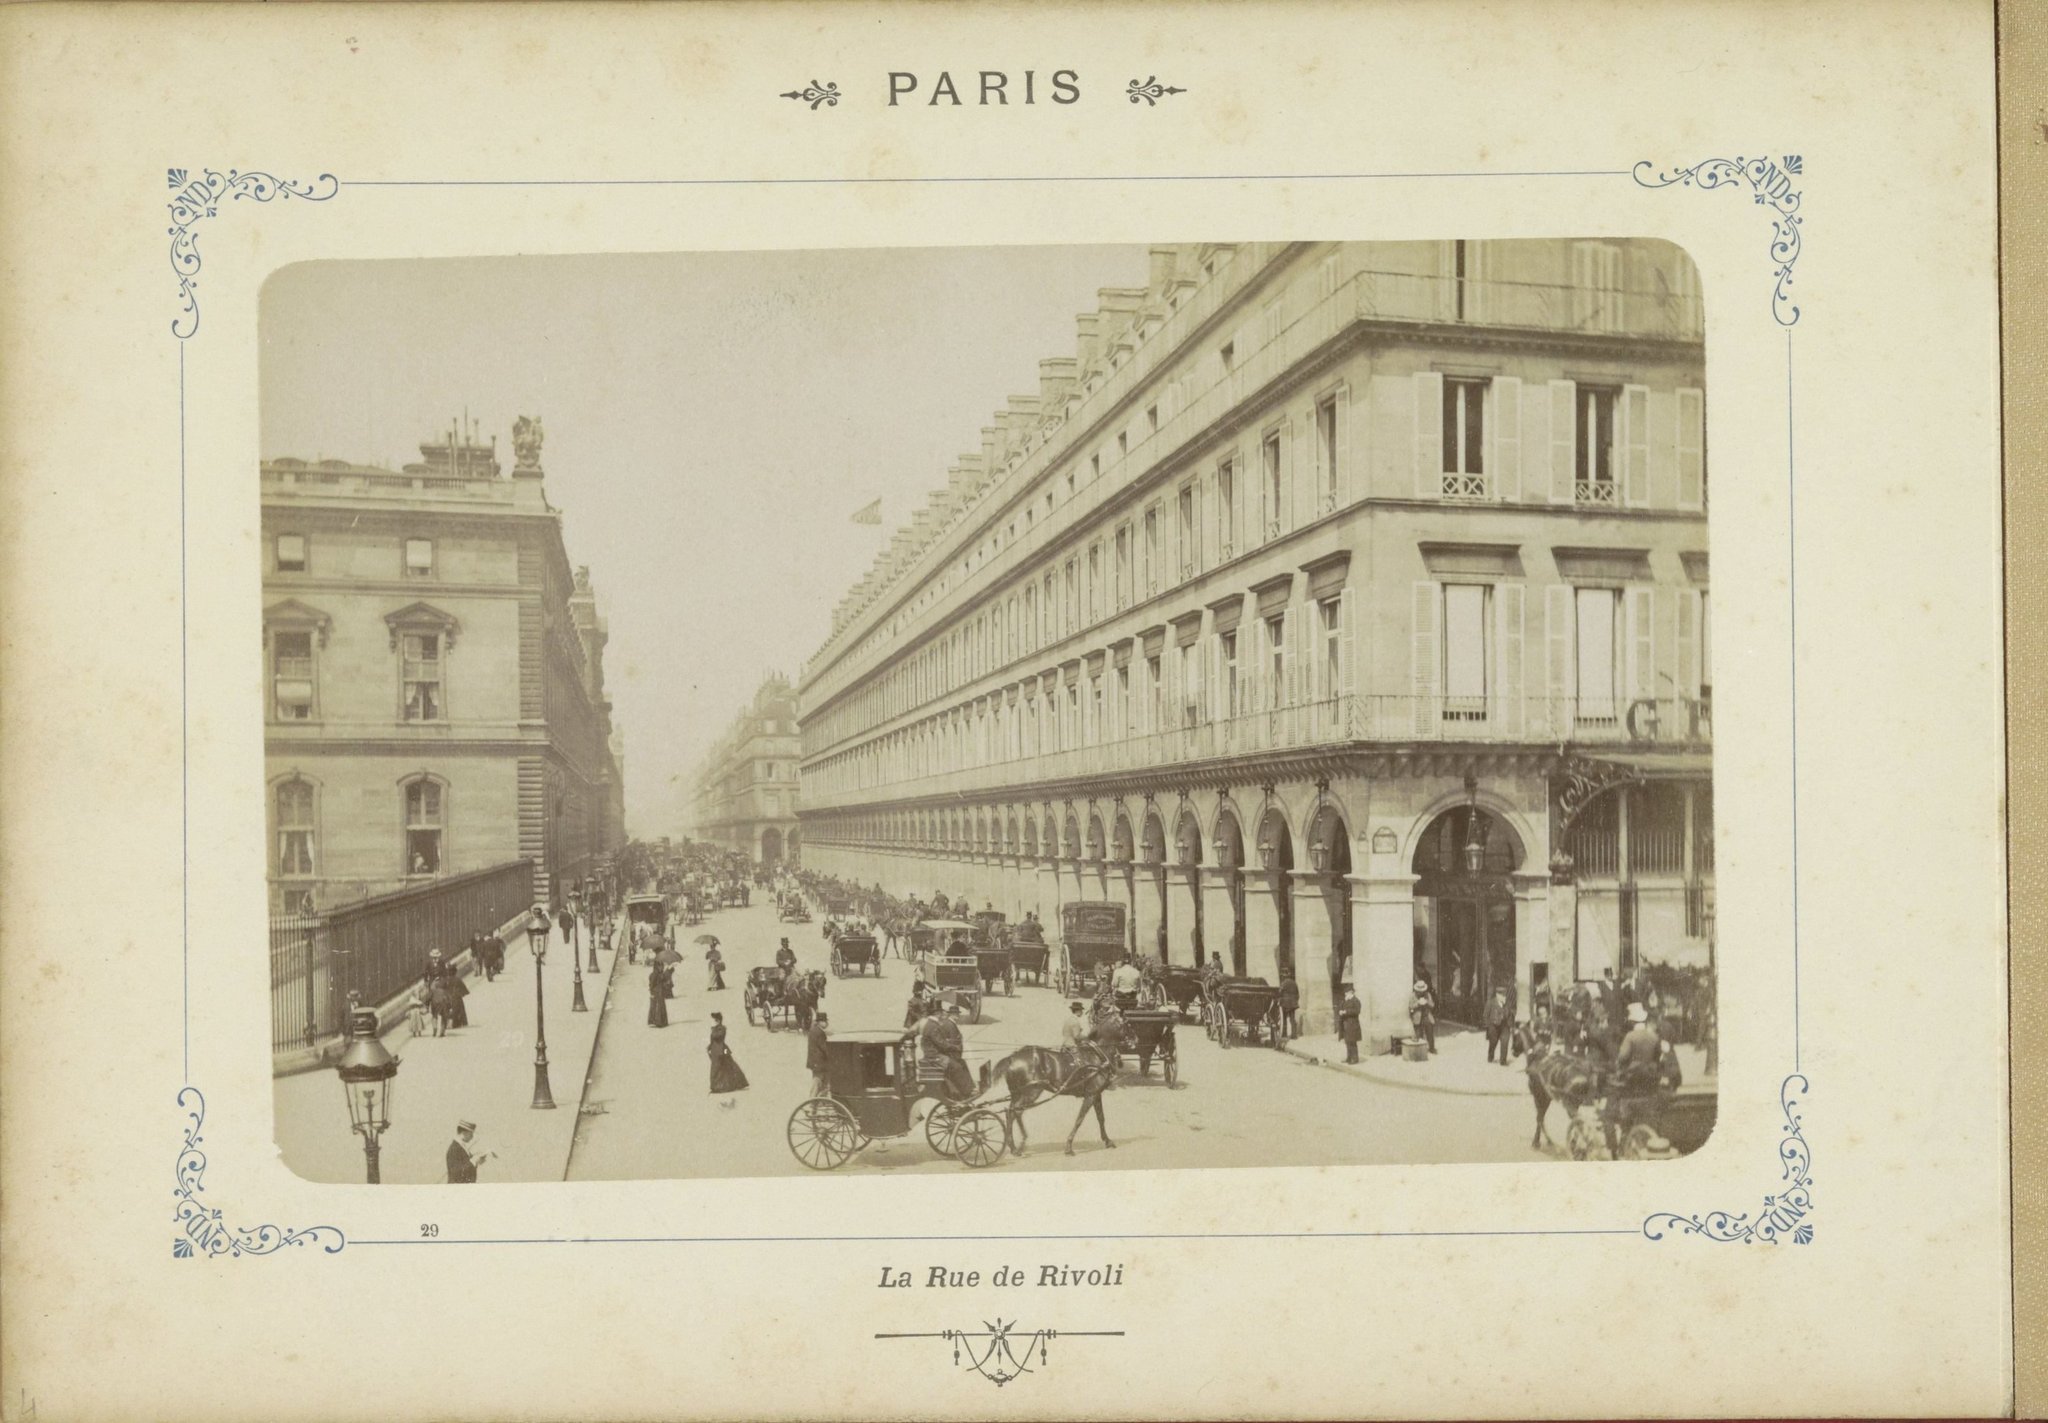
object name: photograph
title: Rue de Rivoli in Parijs met paardenkoetsen en voorbijgangers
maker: Anonymous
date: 1900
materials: cardboard, paper, photographic support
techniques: albumen print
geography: paris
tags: animal traction, animal-drawn vehicle (carriage etc.), street (+ city(-scape) with figures, staffage), paris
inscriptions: number: ‘29’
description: Onderdeel van Fotoalbum met bezienswaardigheden in Parijs, Versailles en het Bois de Boulogne.